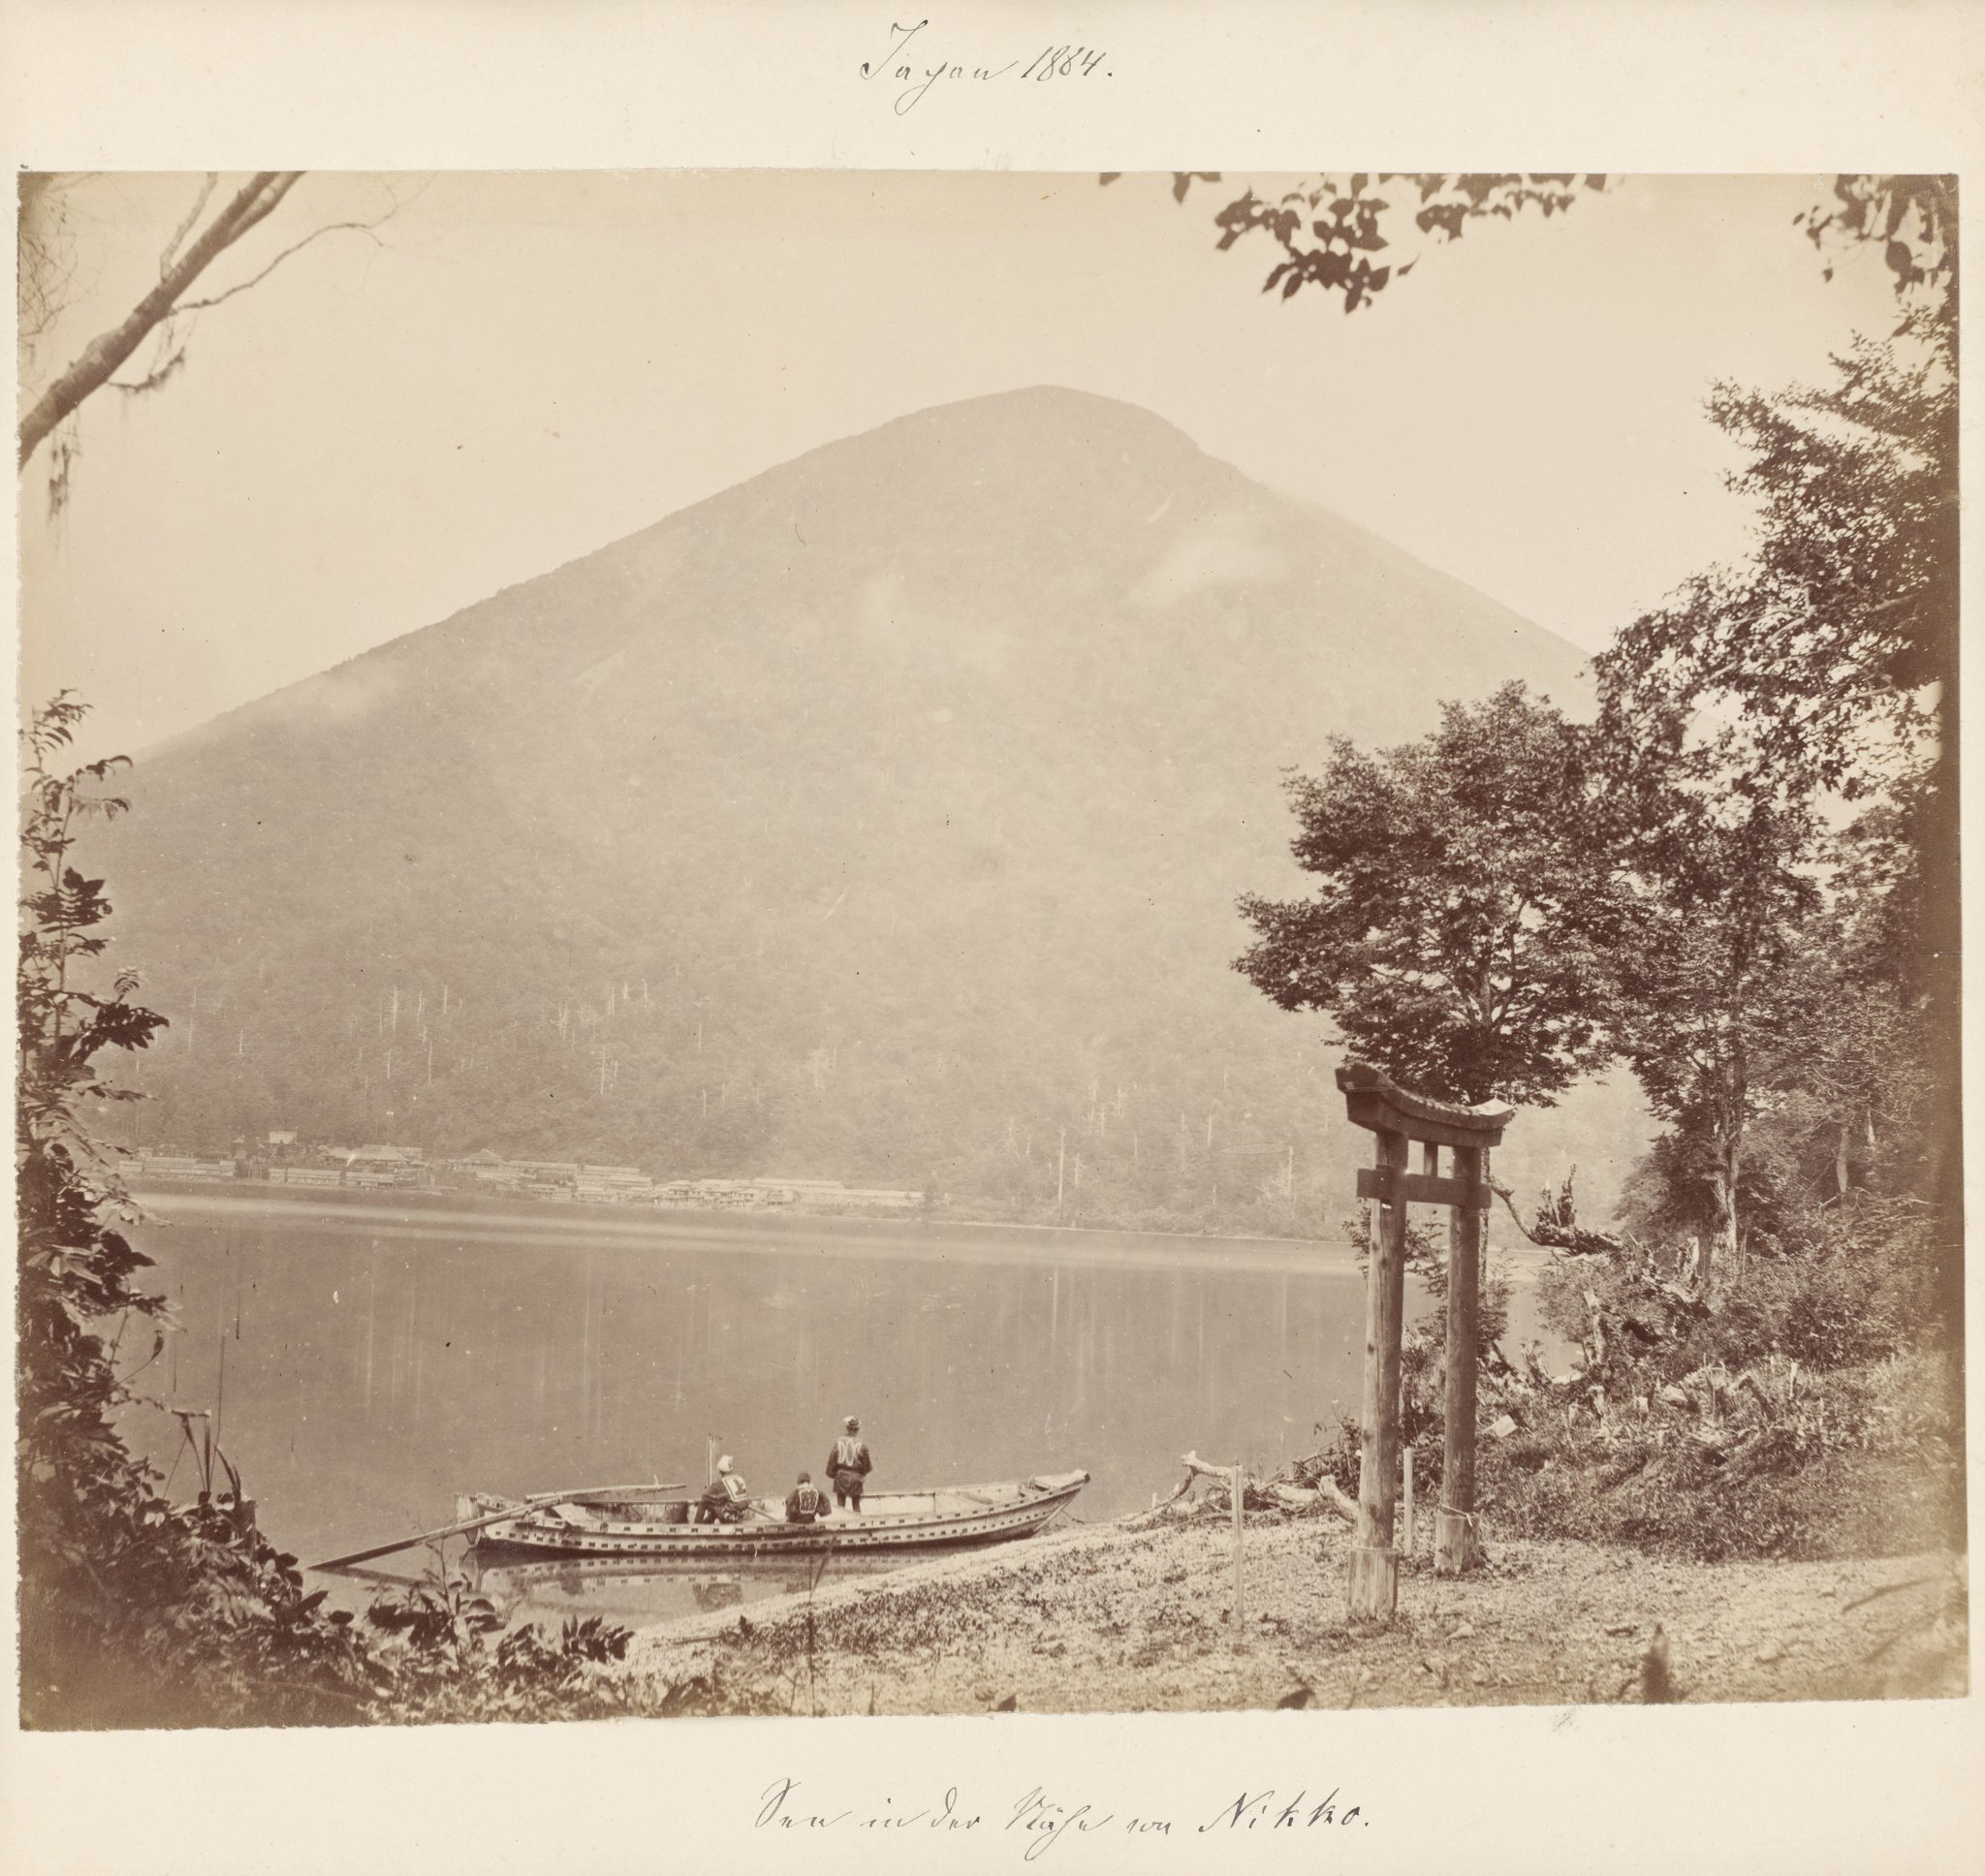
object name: photograph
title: Japan 1884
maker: Anonymous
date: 1884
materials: cardboard, paper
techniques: albumen print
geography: nikko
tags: lake, mountains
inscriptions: inscription: ‘See in der Nähe von Nikko’